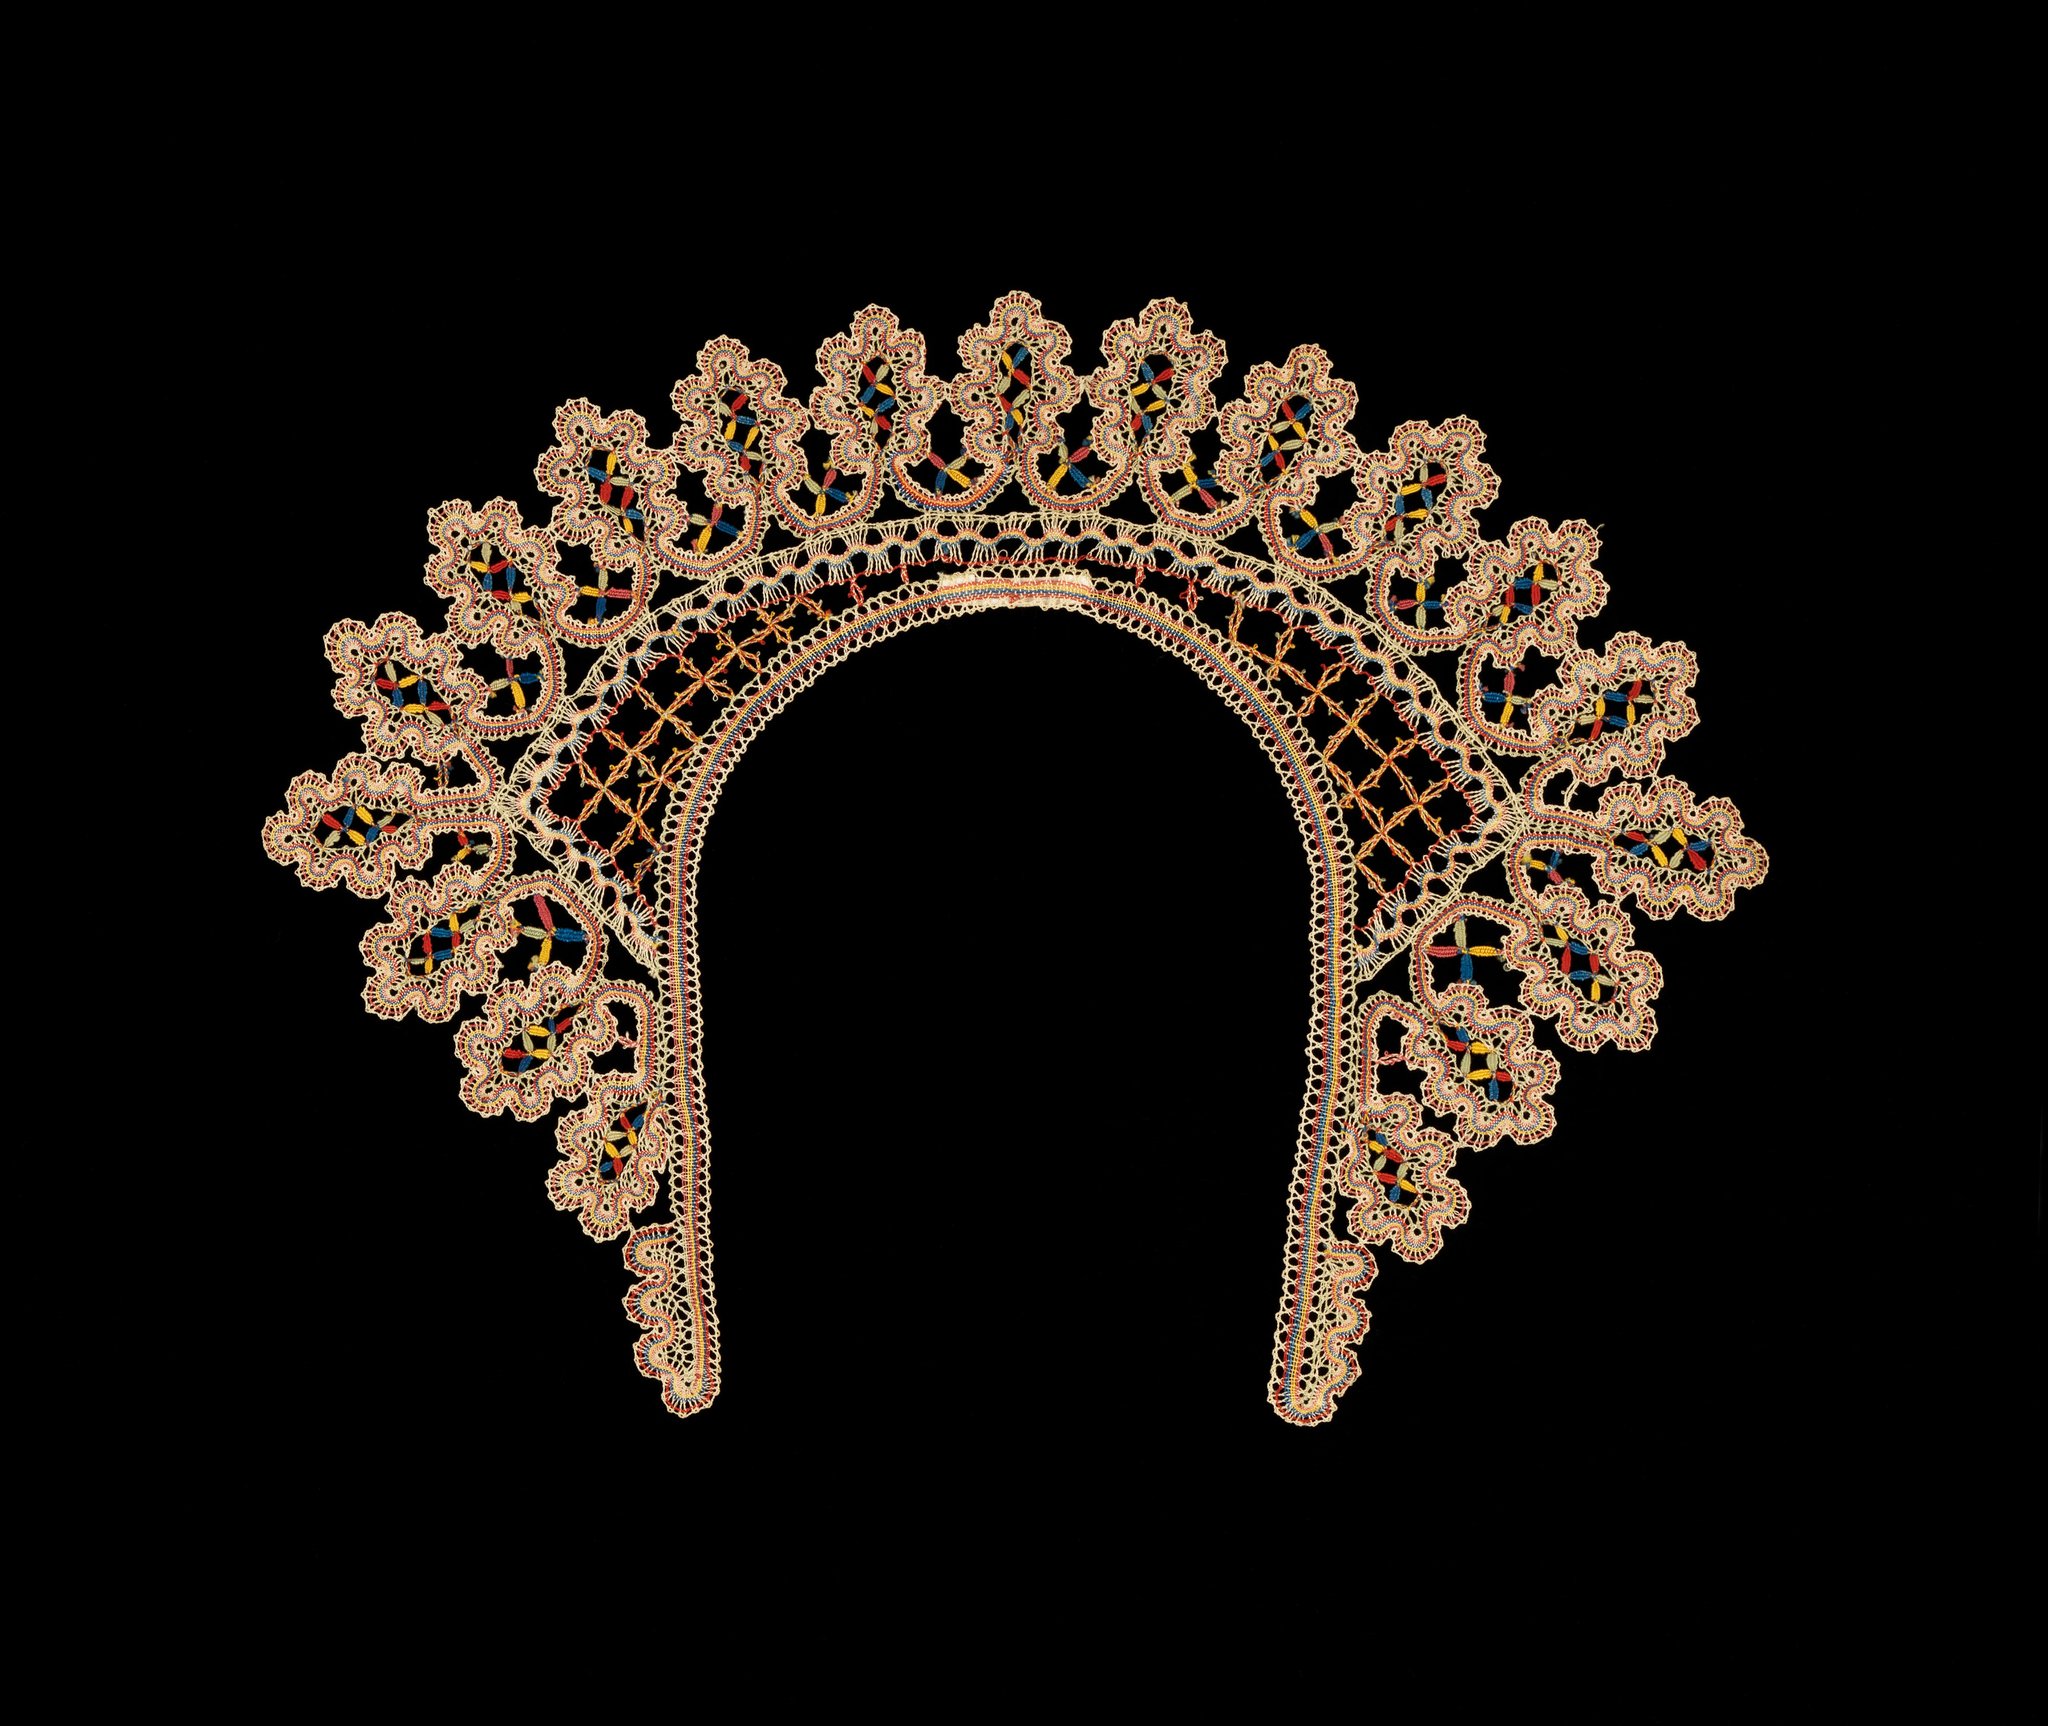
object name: collar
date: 1876-1900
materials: cotton